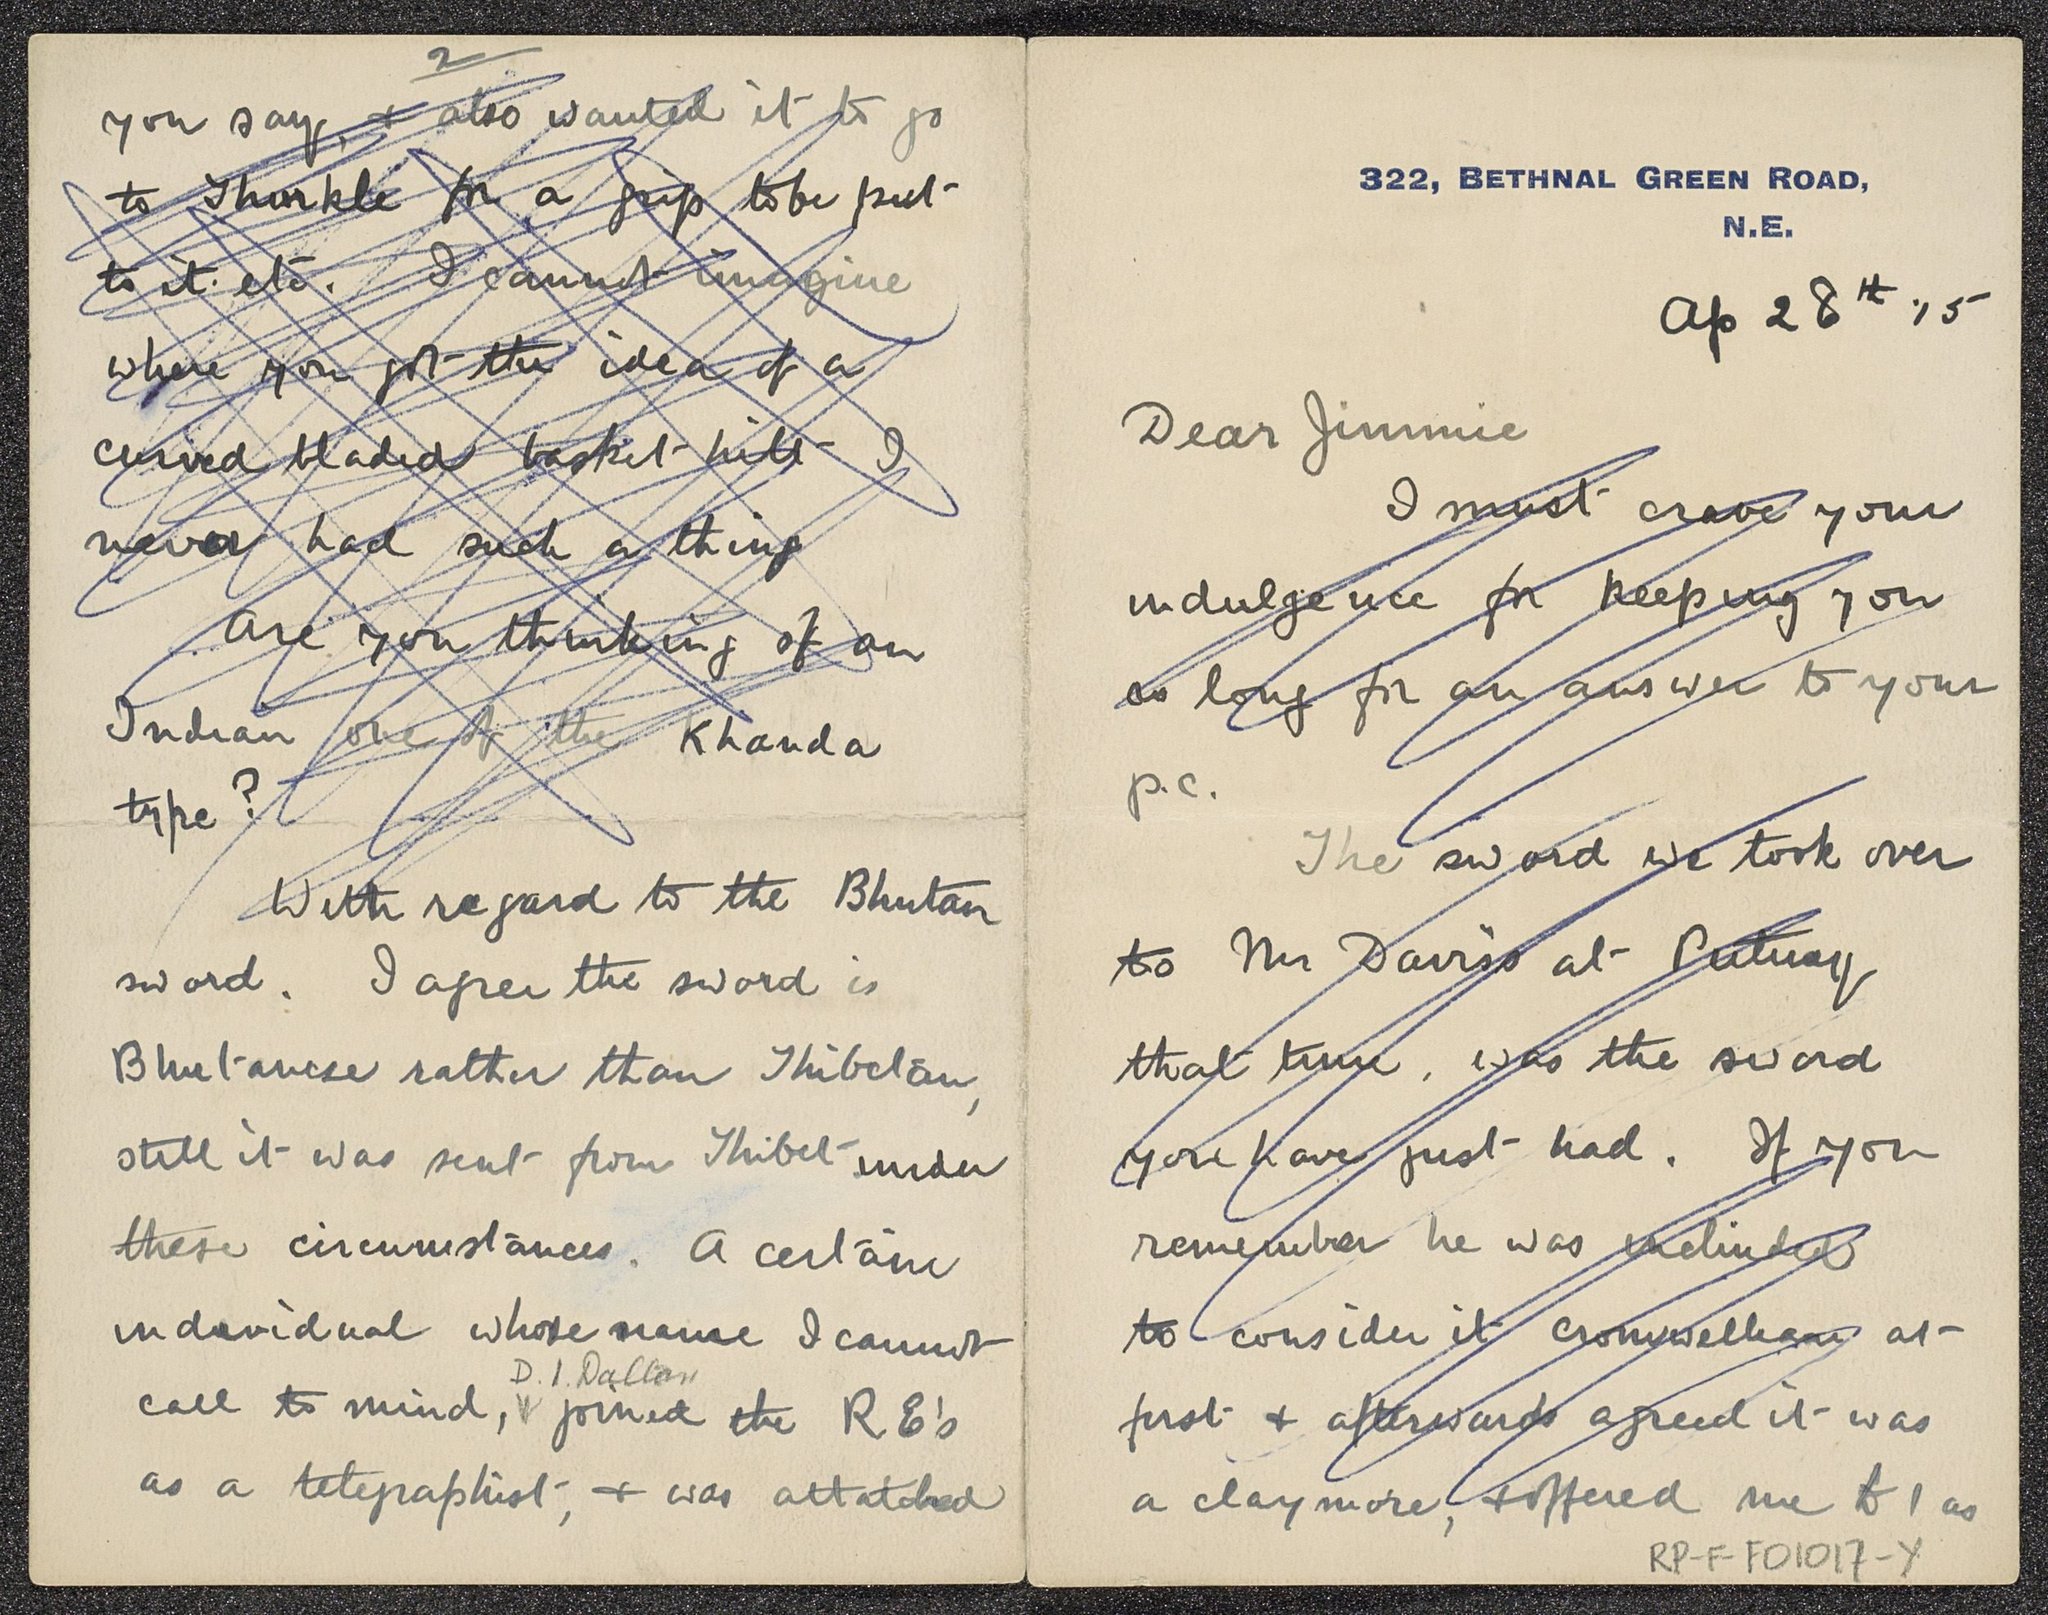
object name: letter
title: Brief met herkomstgegevens van het Tibetaanse fotoalbum van legertelegrafist D.T. Dalton (pagina 1 en 2)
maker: Anonymous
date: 1915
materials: paper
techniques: writing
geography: london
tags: letter, envelope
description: Brief gedateerd 28 april 1915, gericht aan 'Jimmie', naam afzender deels onleesbaar, briefhoofd '322, Bethnal Green Road, N.E.', tekst deels doorgestreept. Vermeld wordt onder meer hoe het fotoalbum vanuit Tibet in Groot-Brittannië terecht is gekomen. Onderdeel van Fotoalbum met 24 foto's van de reis van legertelegrafist D.T. Dalton door Tibet.